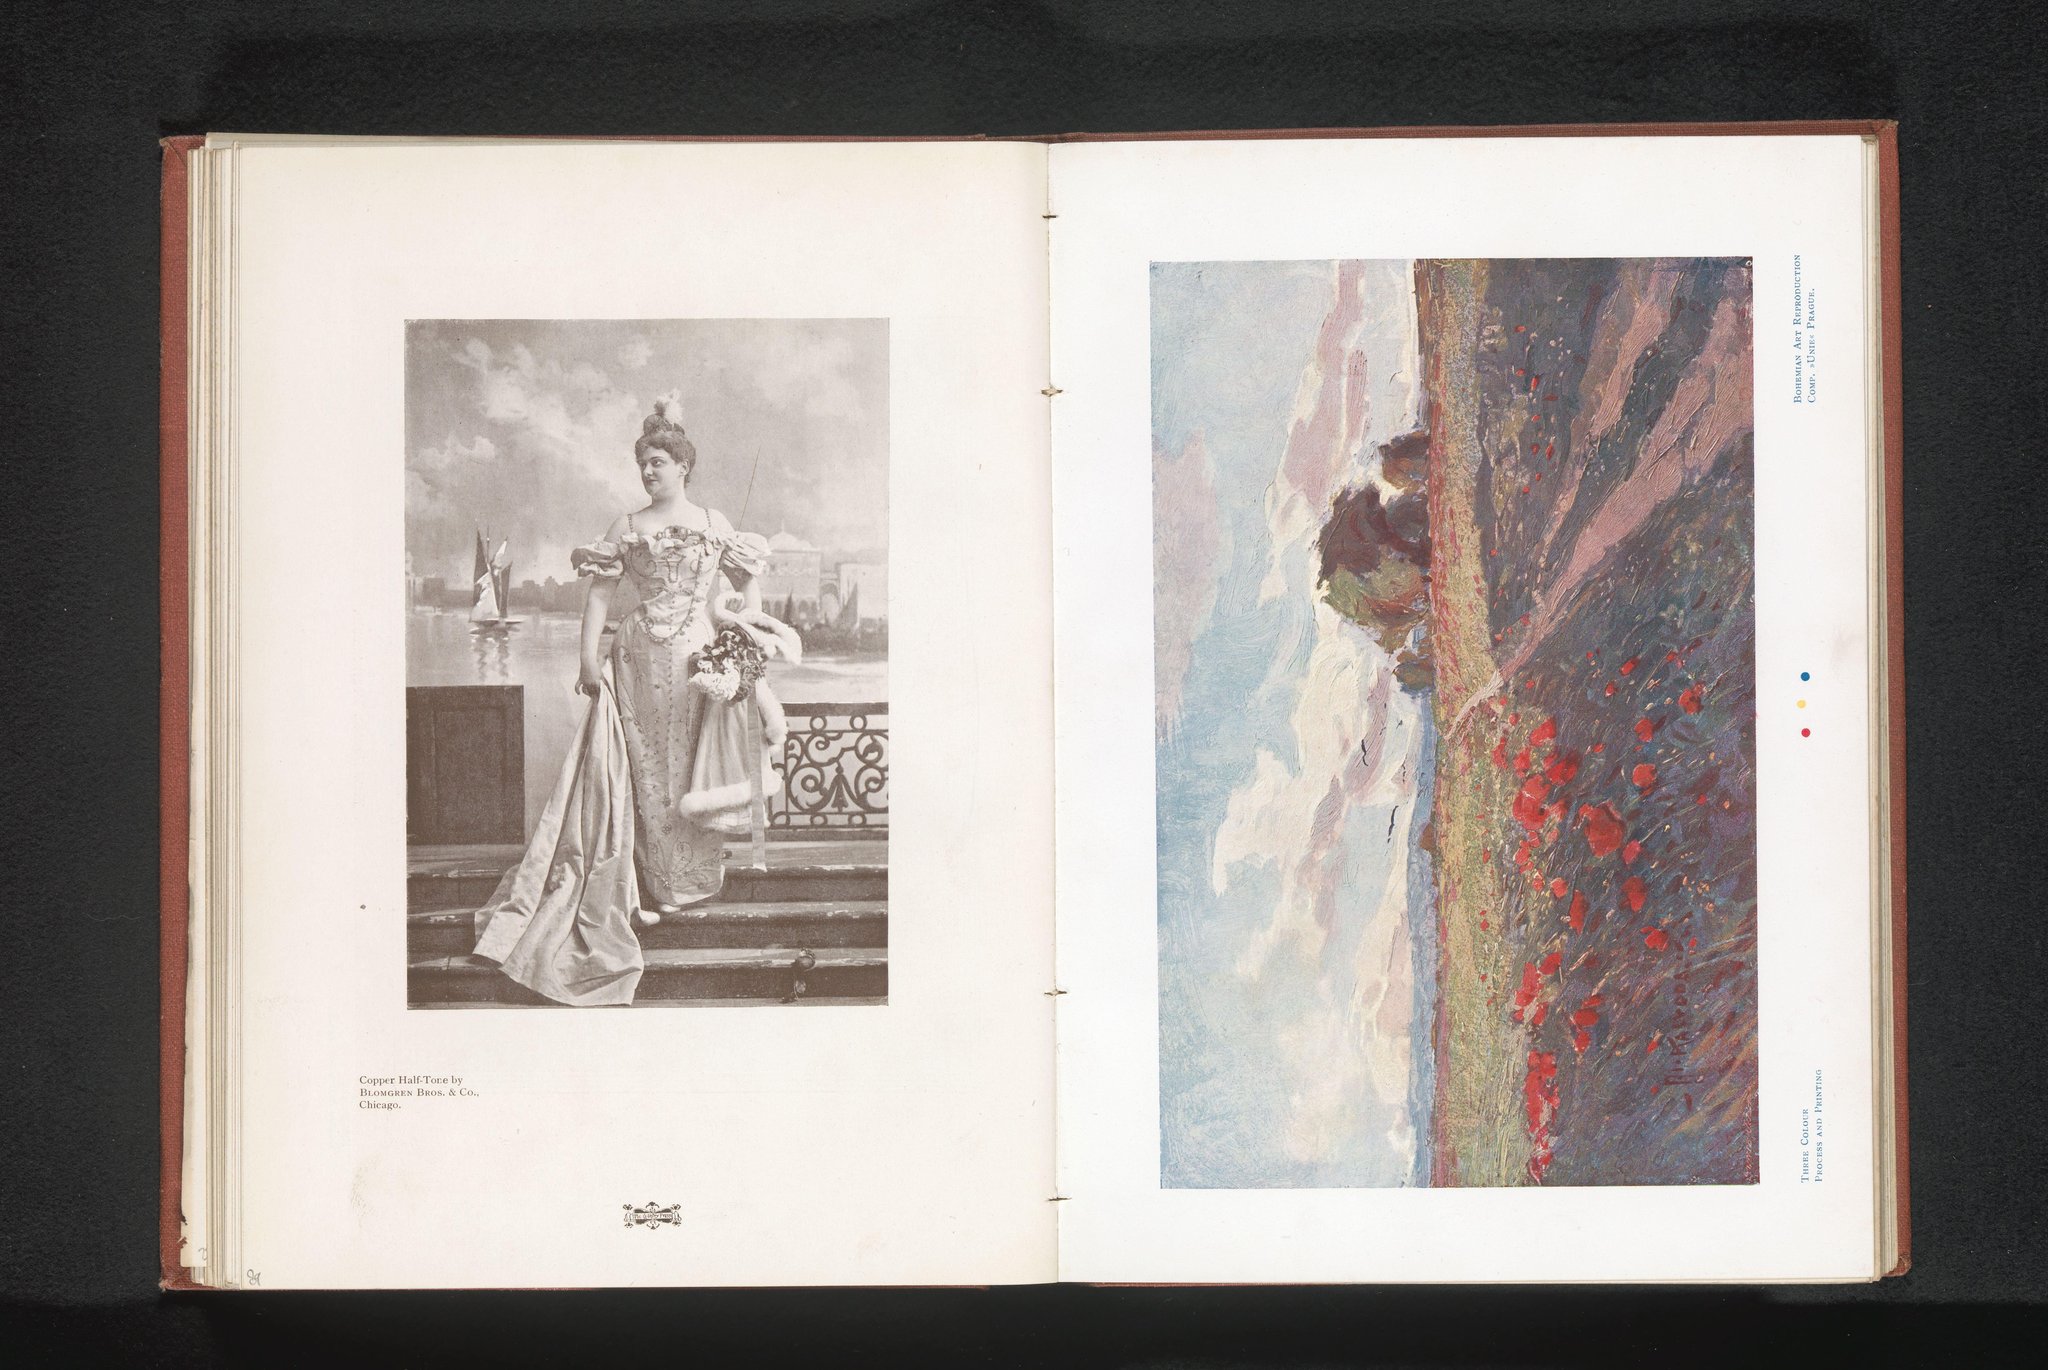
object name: photomechanical print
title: Studioportret van een onbekende vrouw in jurk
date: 1895-1900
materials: paper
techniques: autotype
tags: historical persons - bb - woman, dress, gown: evening dress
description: Prent op achtste ongenummerde pagina na pagina 68.